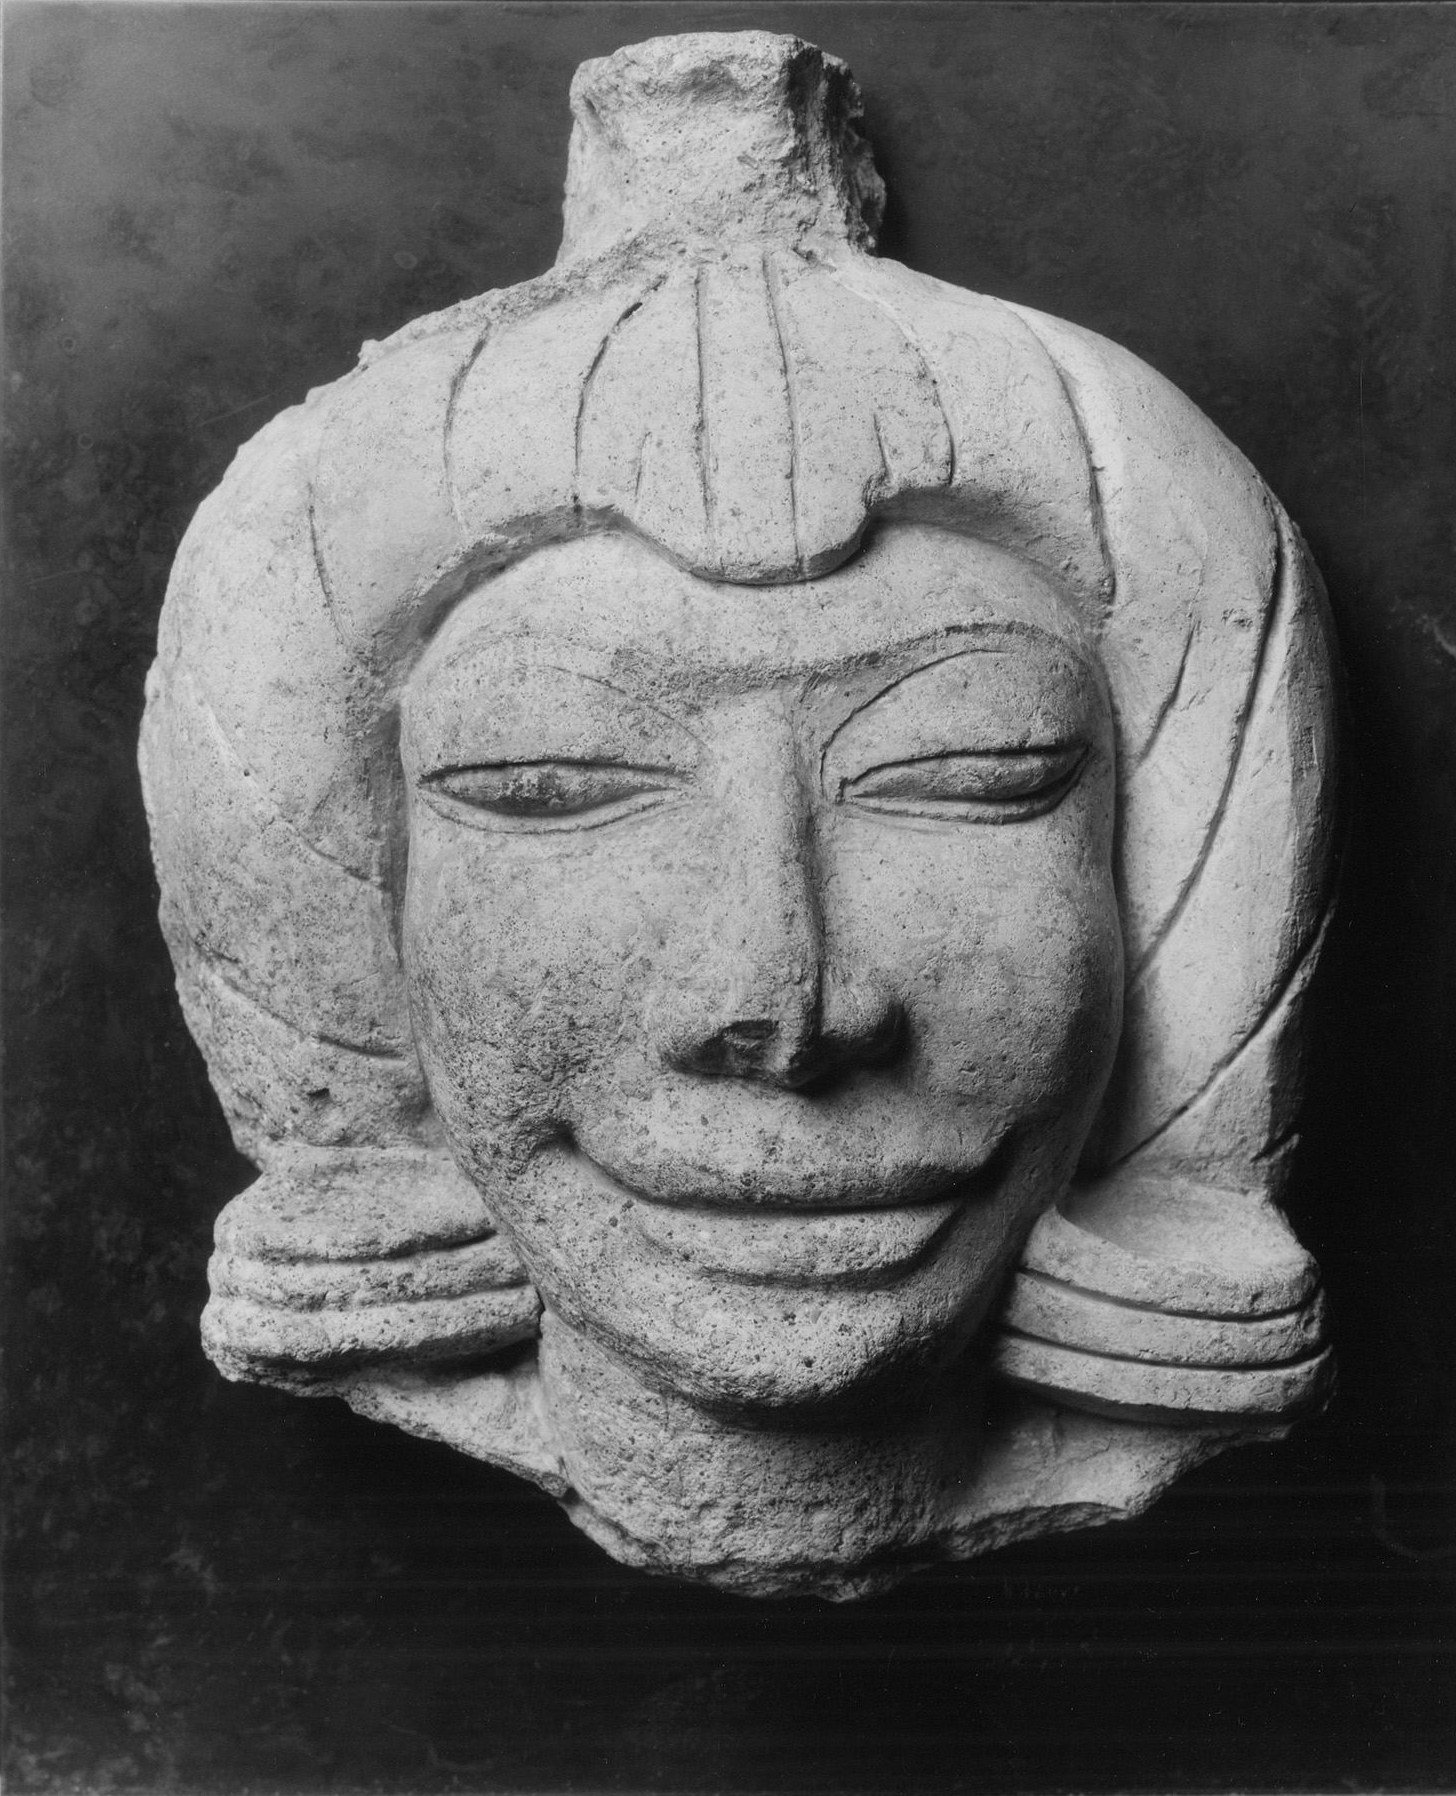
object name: head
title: Head of a Male Figure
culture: thai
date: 701-900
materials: plaster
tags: faces,heads,men